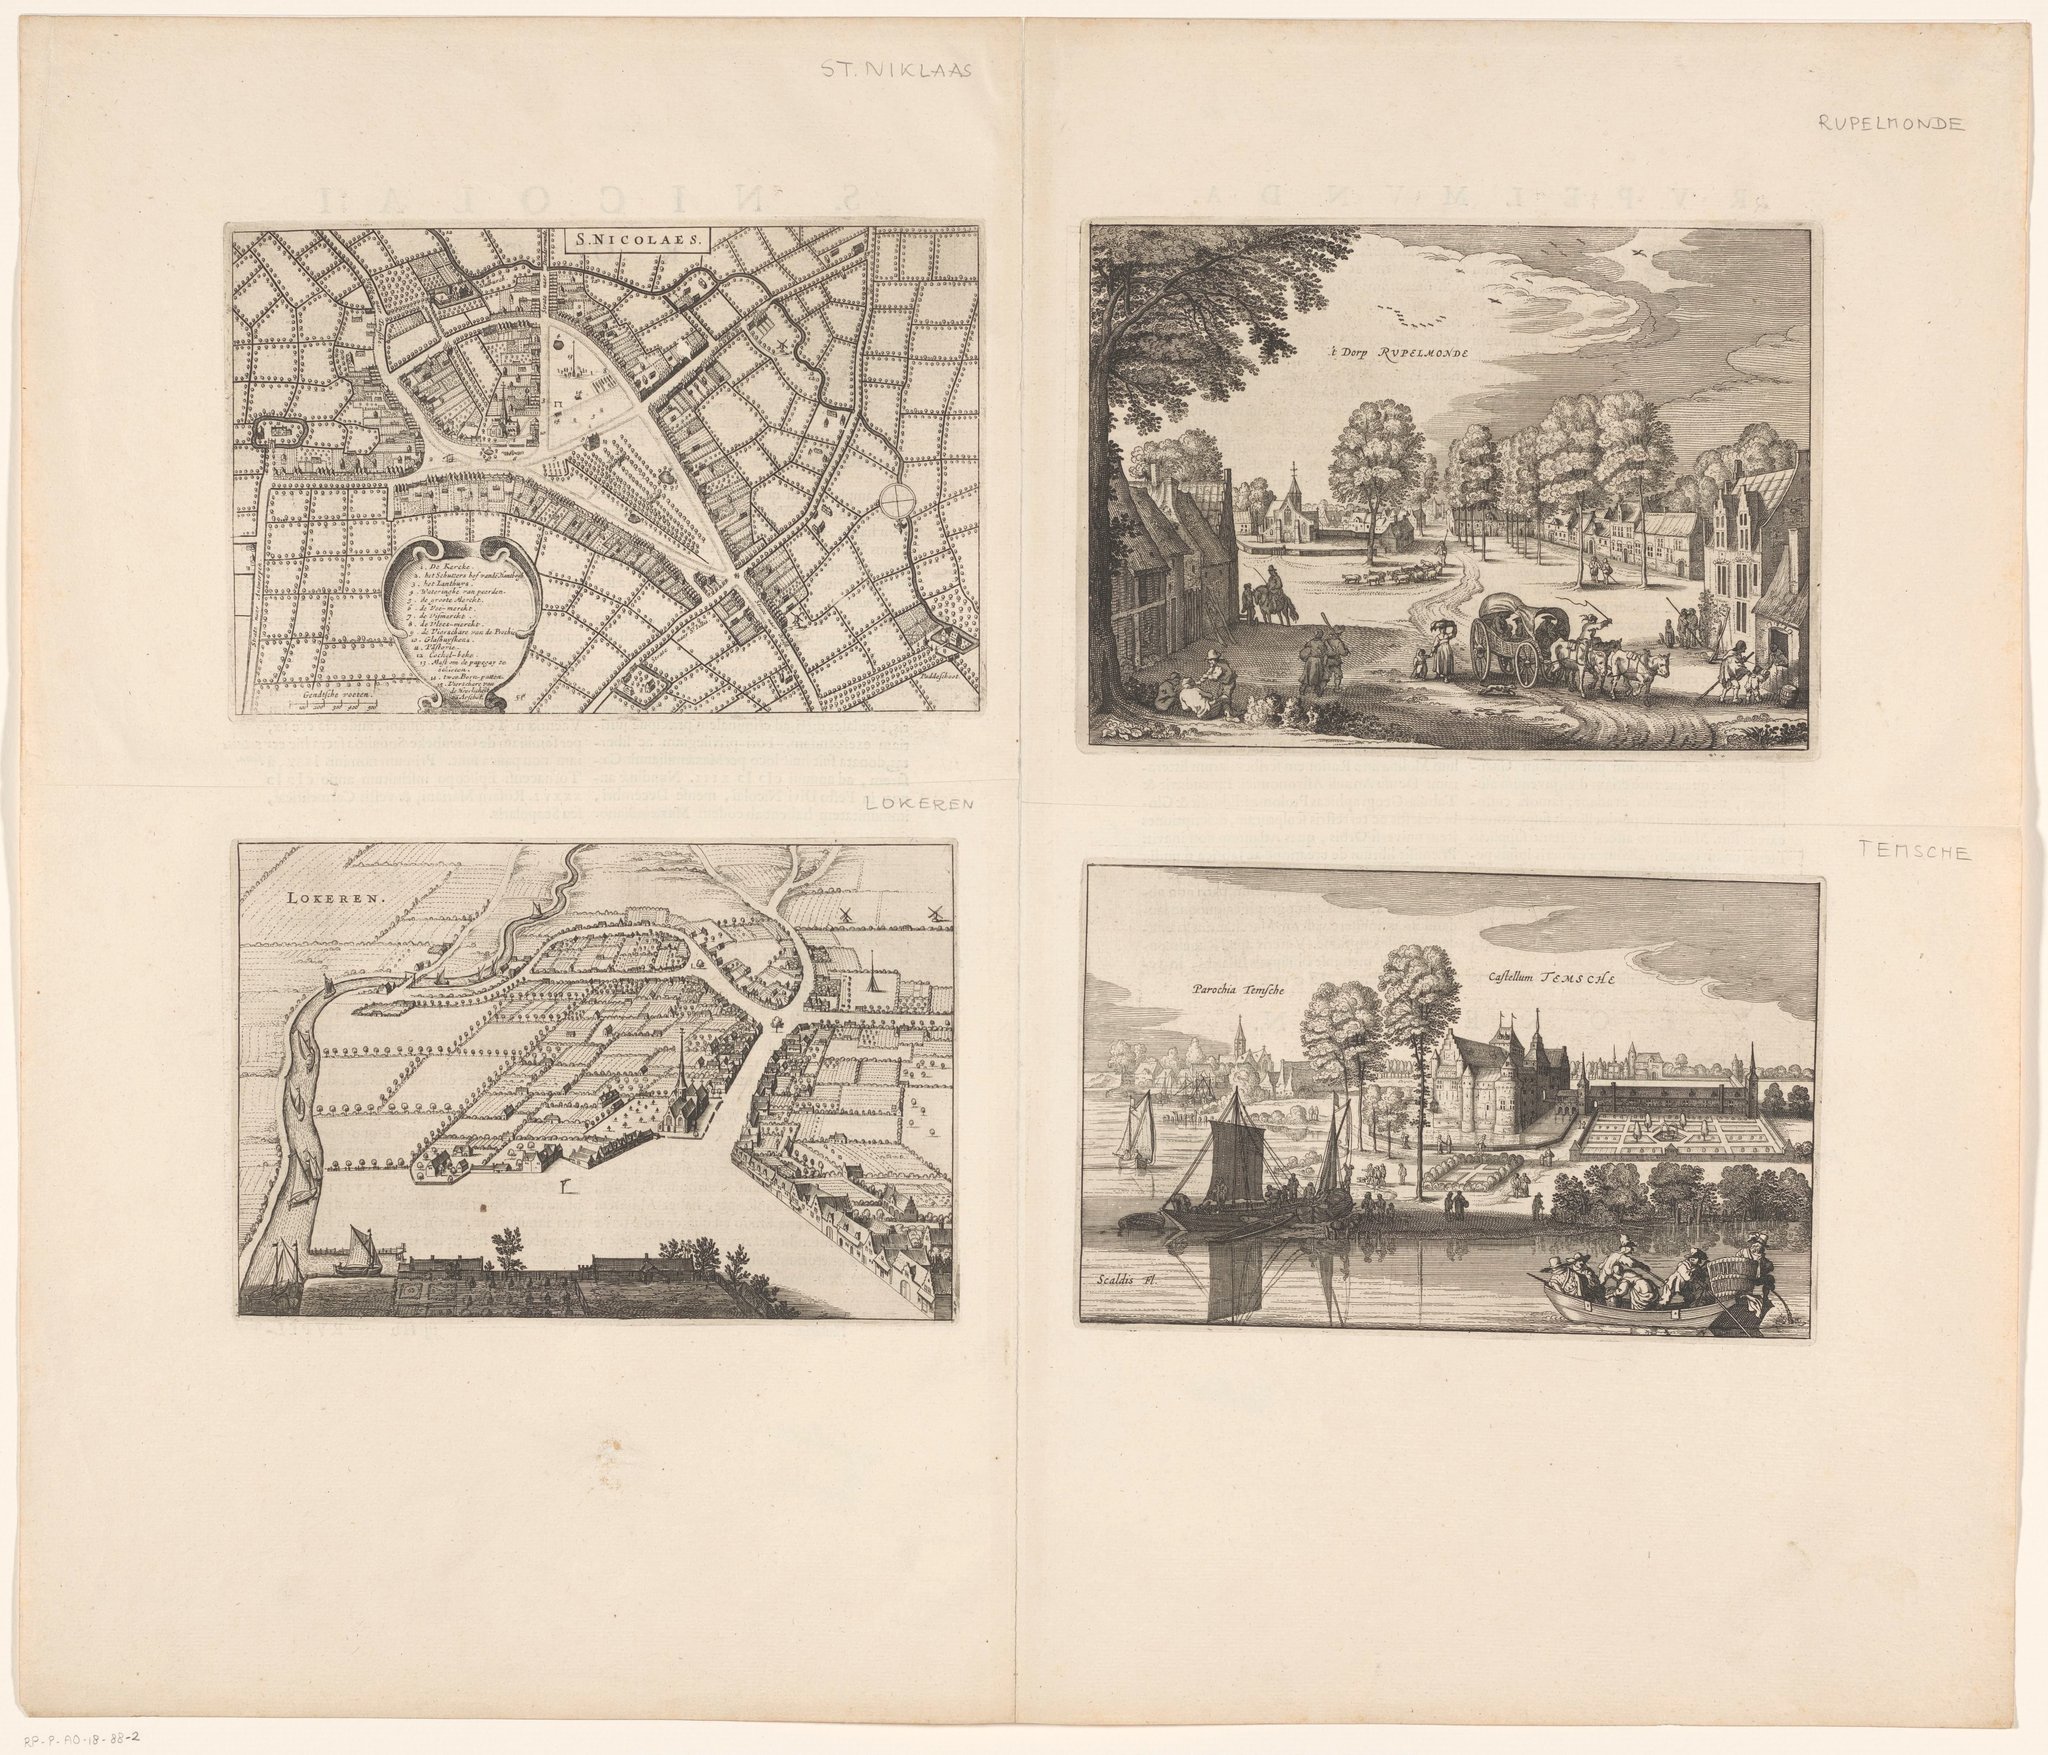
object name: print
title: Plattegrond van Sint-Niklaas en gezichten op Rupelmonde, het Kasteel van Temse en Lokeren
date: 1652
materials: paper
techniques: engraving, etching, letterpress printing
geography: amsterdam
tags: prospect of village, silhouette of village, geodesy, surveying, castle, herding, herdsman, herdswoman, shepherd, shepherdess, cowherd, etc., rowing-boat, canoe, etc., beggar, maps of cities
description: Linksboven een plattegrond van Sint-Niklaas, met gebouwen in vogelvluchtperspectief. Onder, links van het midden, een cartouche met legenda 1-14. Links hiervan een schaalstok: 500 Gendtsche voeten. Rechtsboven een gezicht op Rupelmonde met onder andere een koets, een bedelaar en een herder met schaapskudde. Rechtsonder een gezicht op het Kasteel van Temse, gezien vanaf de Schelde. Linksonder een gezicht in vogelvluchtperspectief op Lokeren. Met Latijnse tekst op verso.